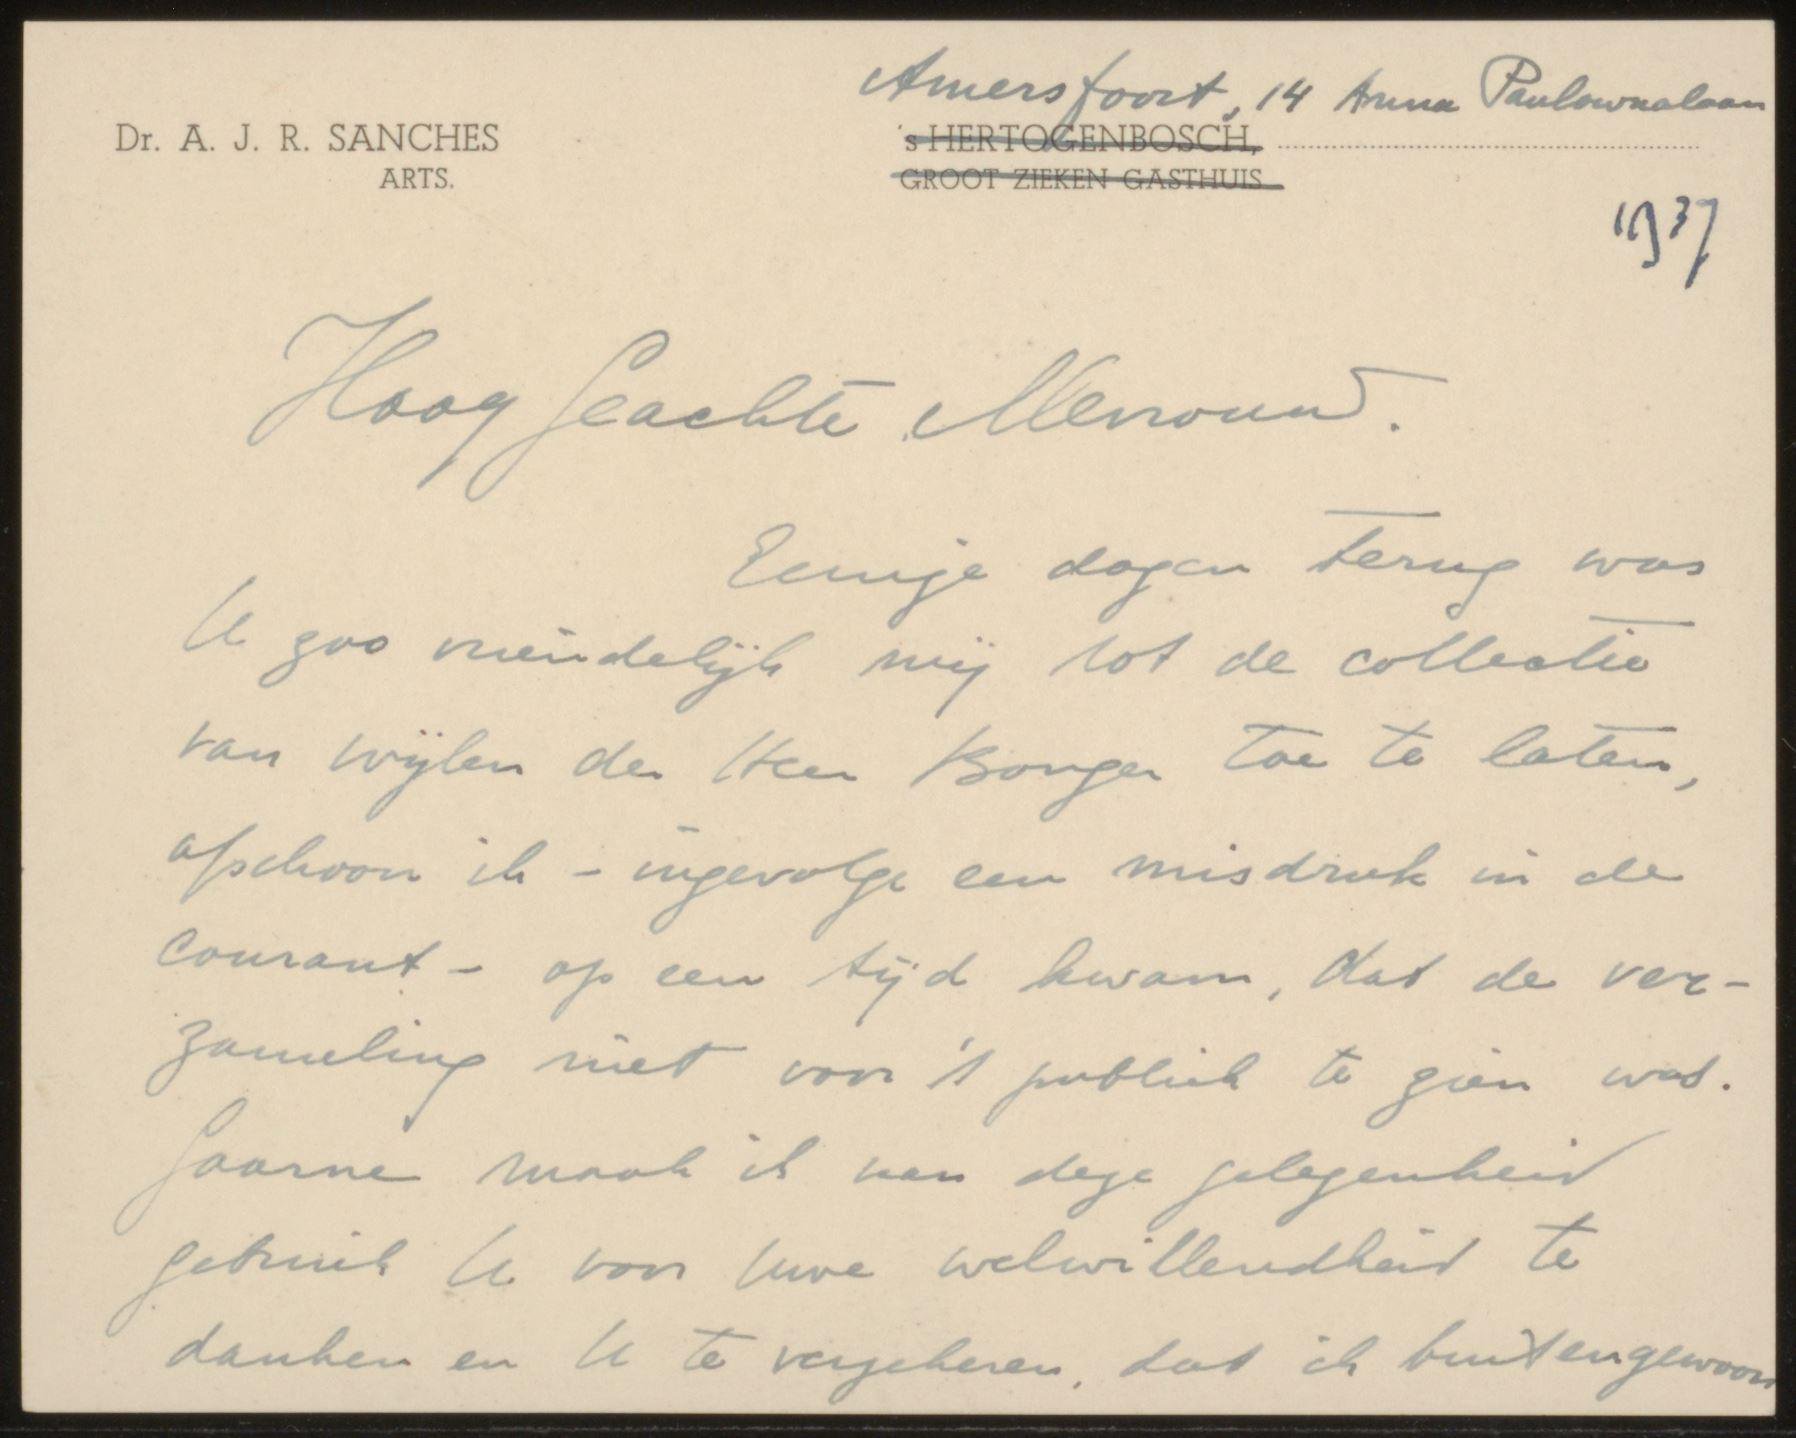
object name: letter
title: Brief aan Françoise W.M. Bonger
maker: antonio nunes ribeiro sanches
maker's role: arts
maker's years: 1699-1783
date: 1938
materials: ink, paper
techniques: pen, writing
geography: amersfoort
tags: painter, odilon redon, print maker, draughtsman, rodolphe bresdin, amsterdam, andries bonger, françoise w.m. bonger